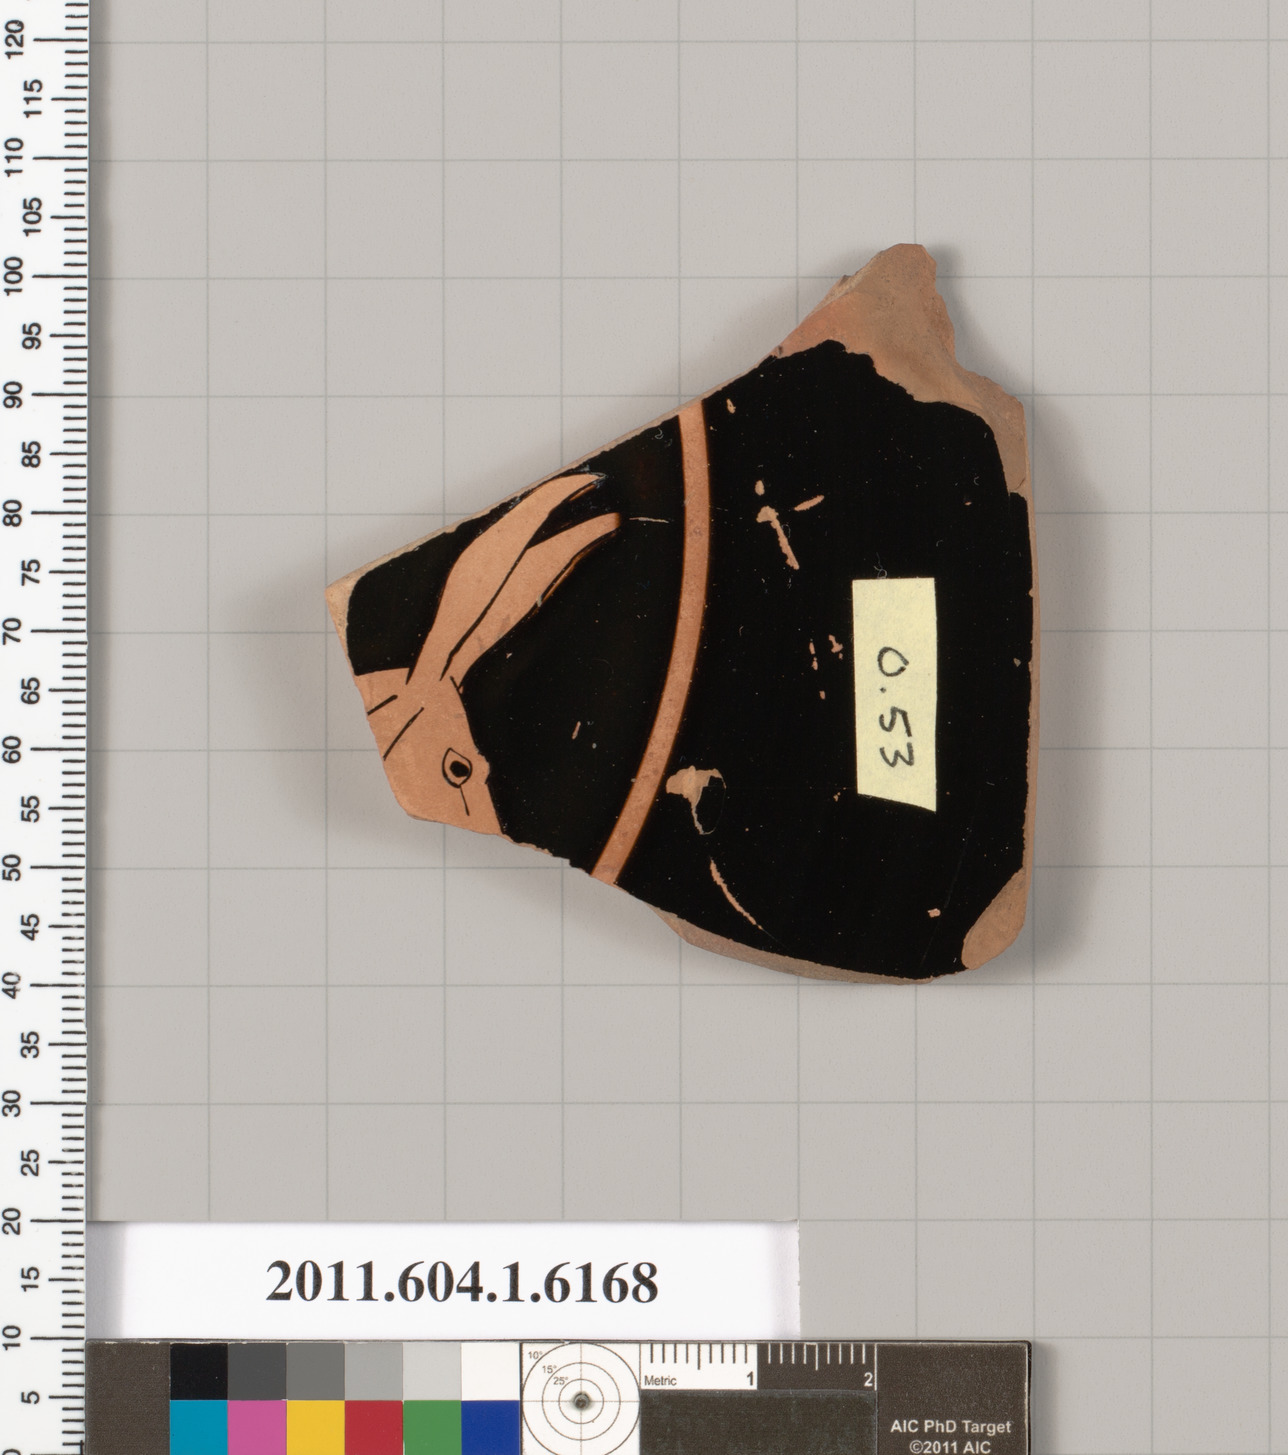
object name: kylix fragment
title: Terracotta fragment of a kylix (drinking cup)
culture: greek, attic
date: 520-500 BCE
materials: terracotta